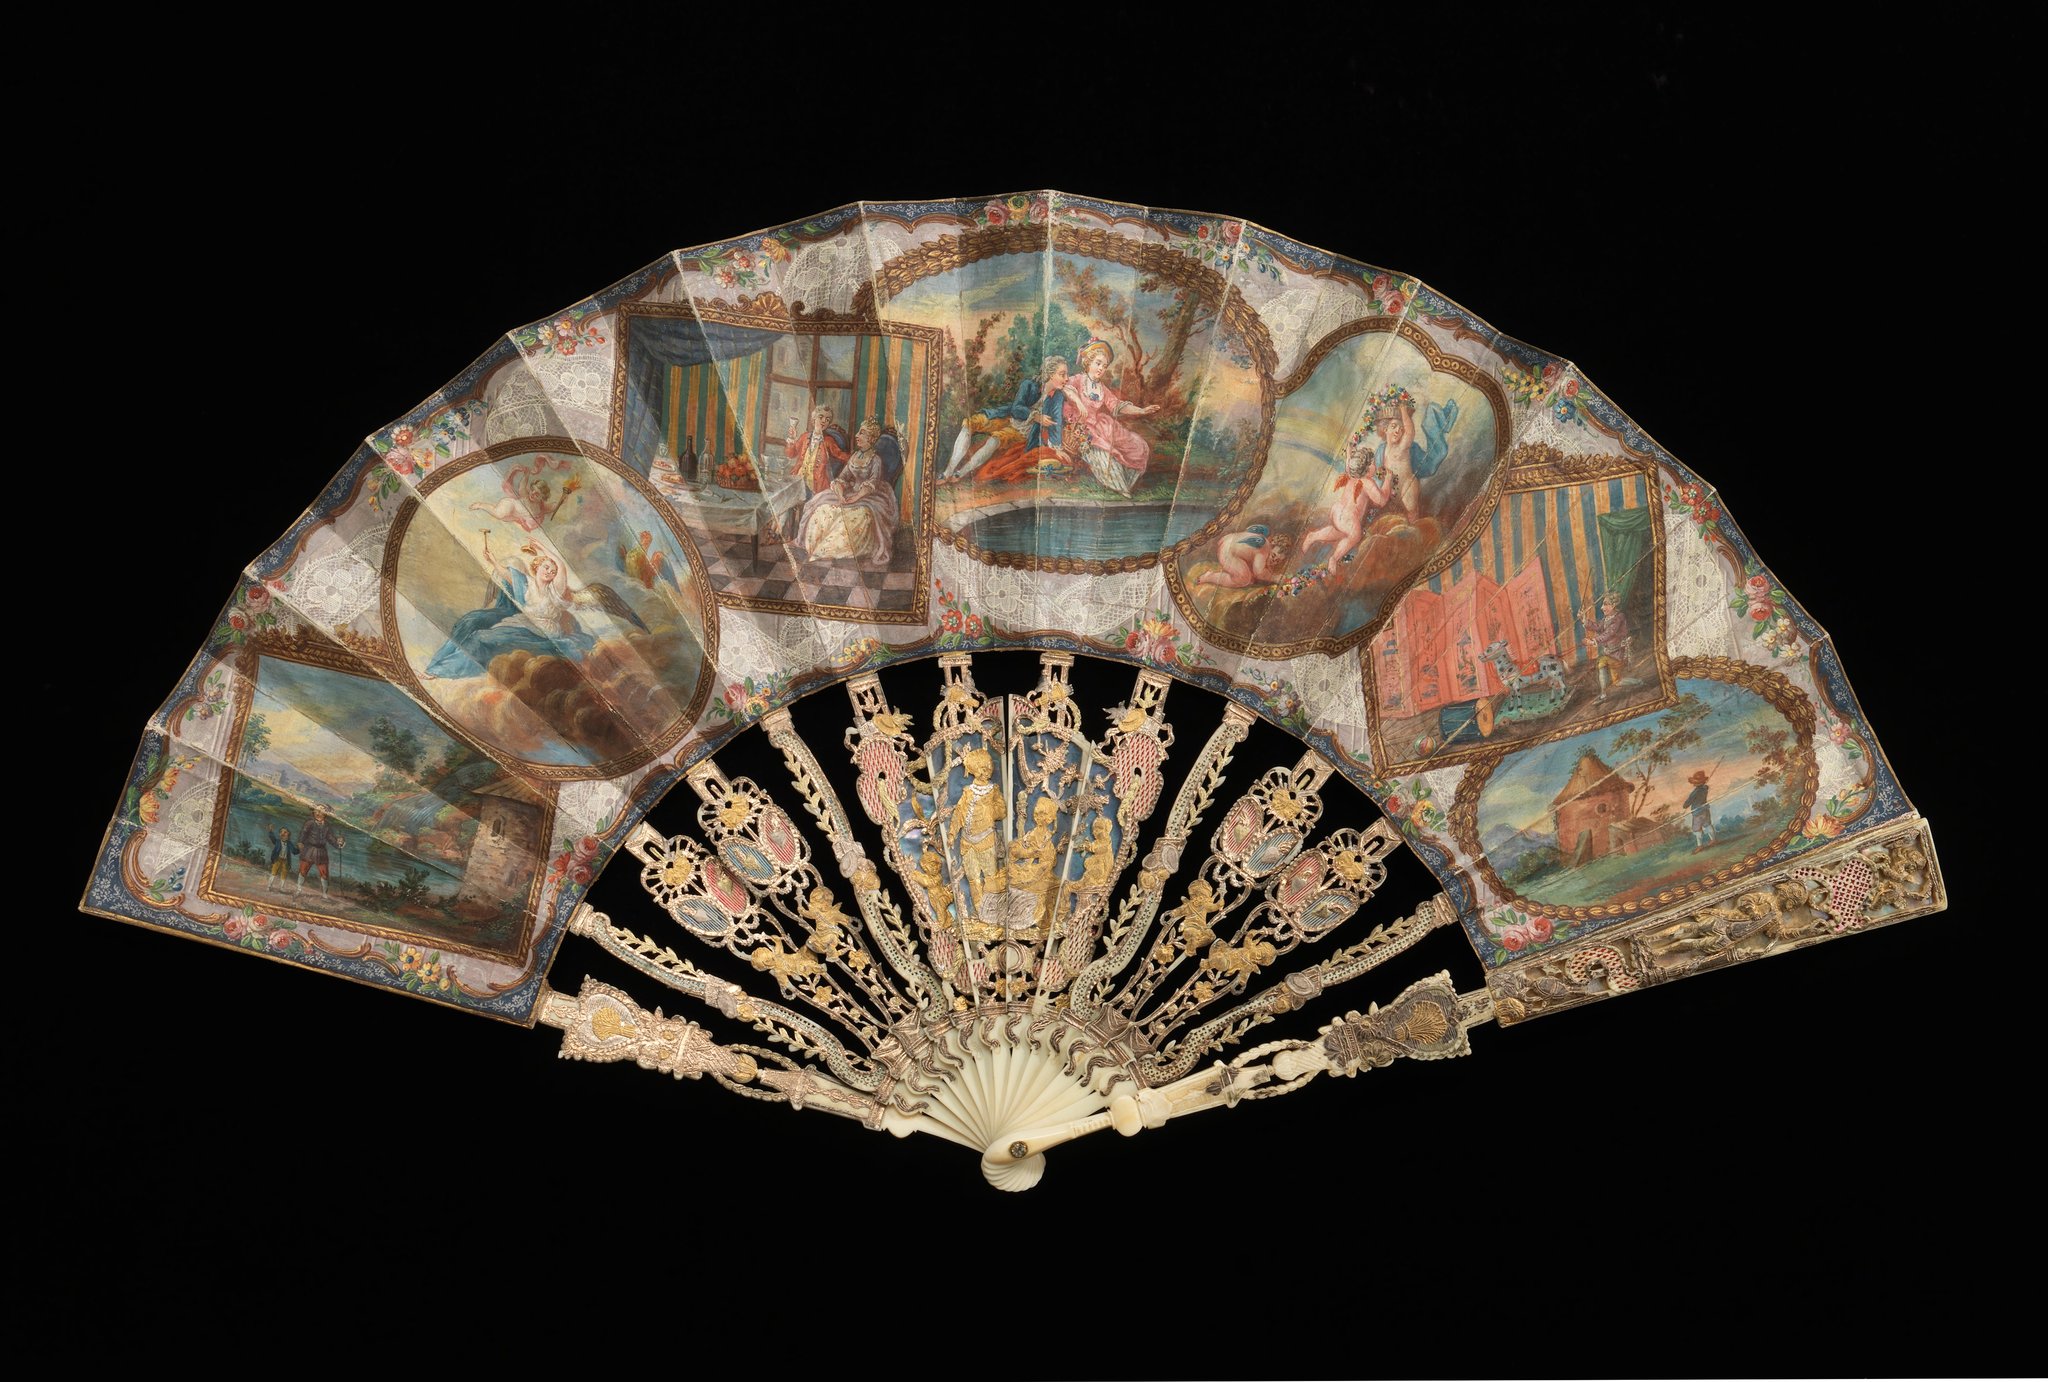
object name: fan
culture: french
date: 1745-1755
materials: gouache, ivory, metal, mother of pearl, paper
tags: children,men,women